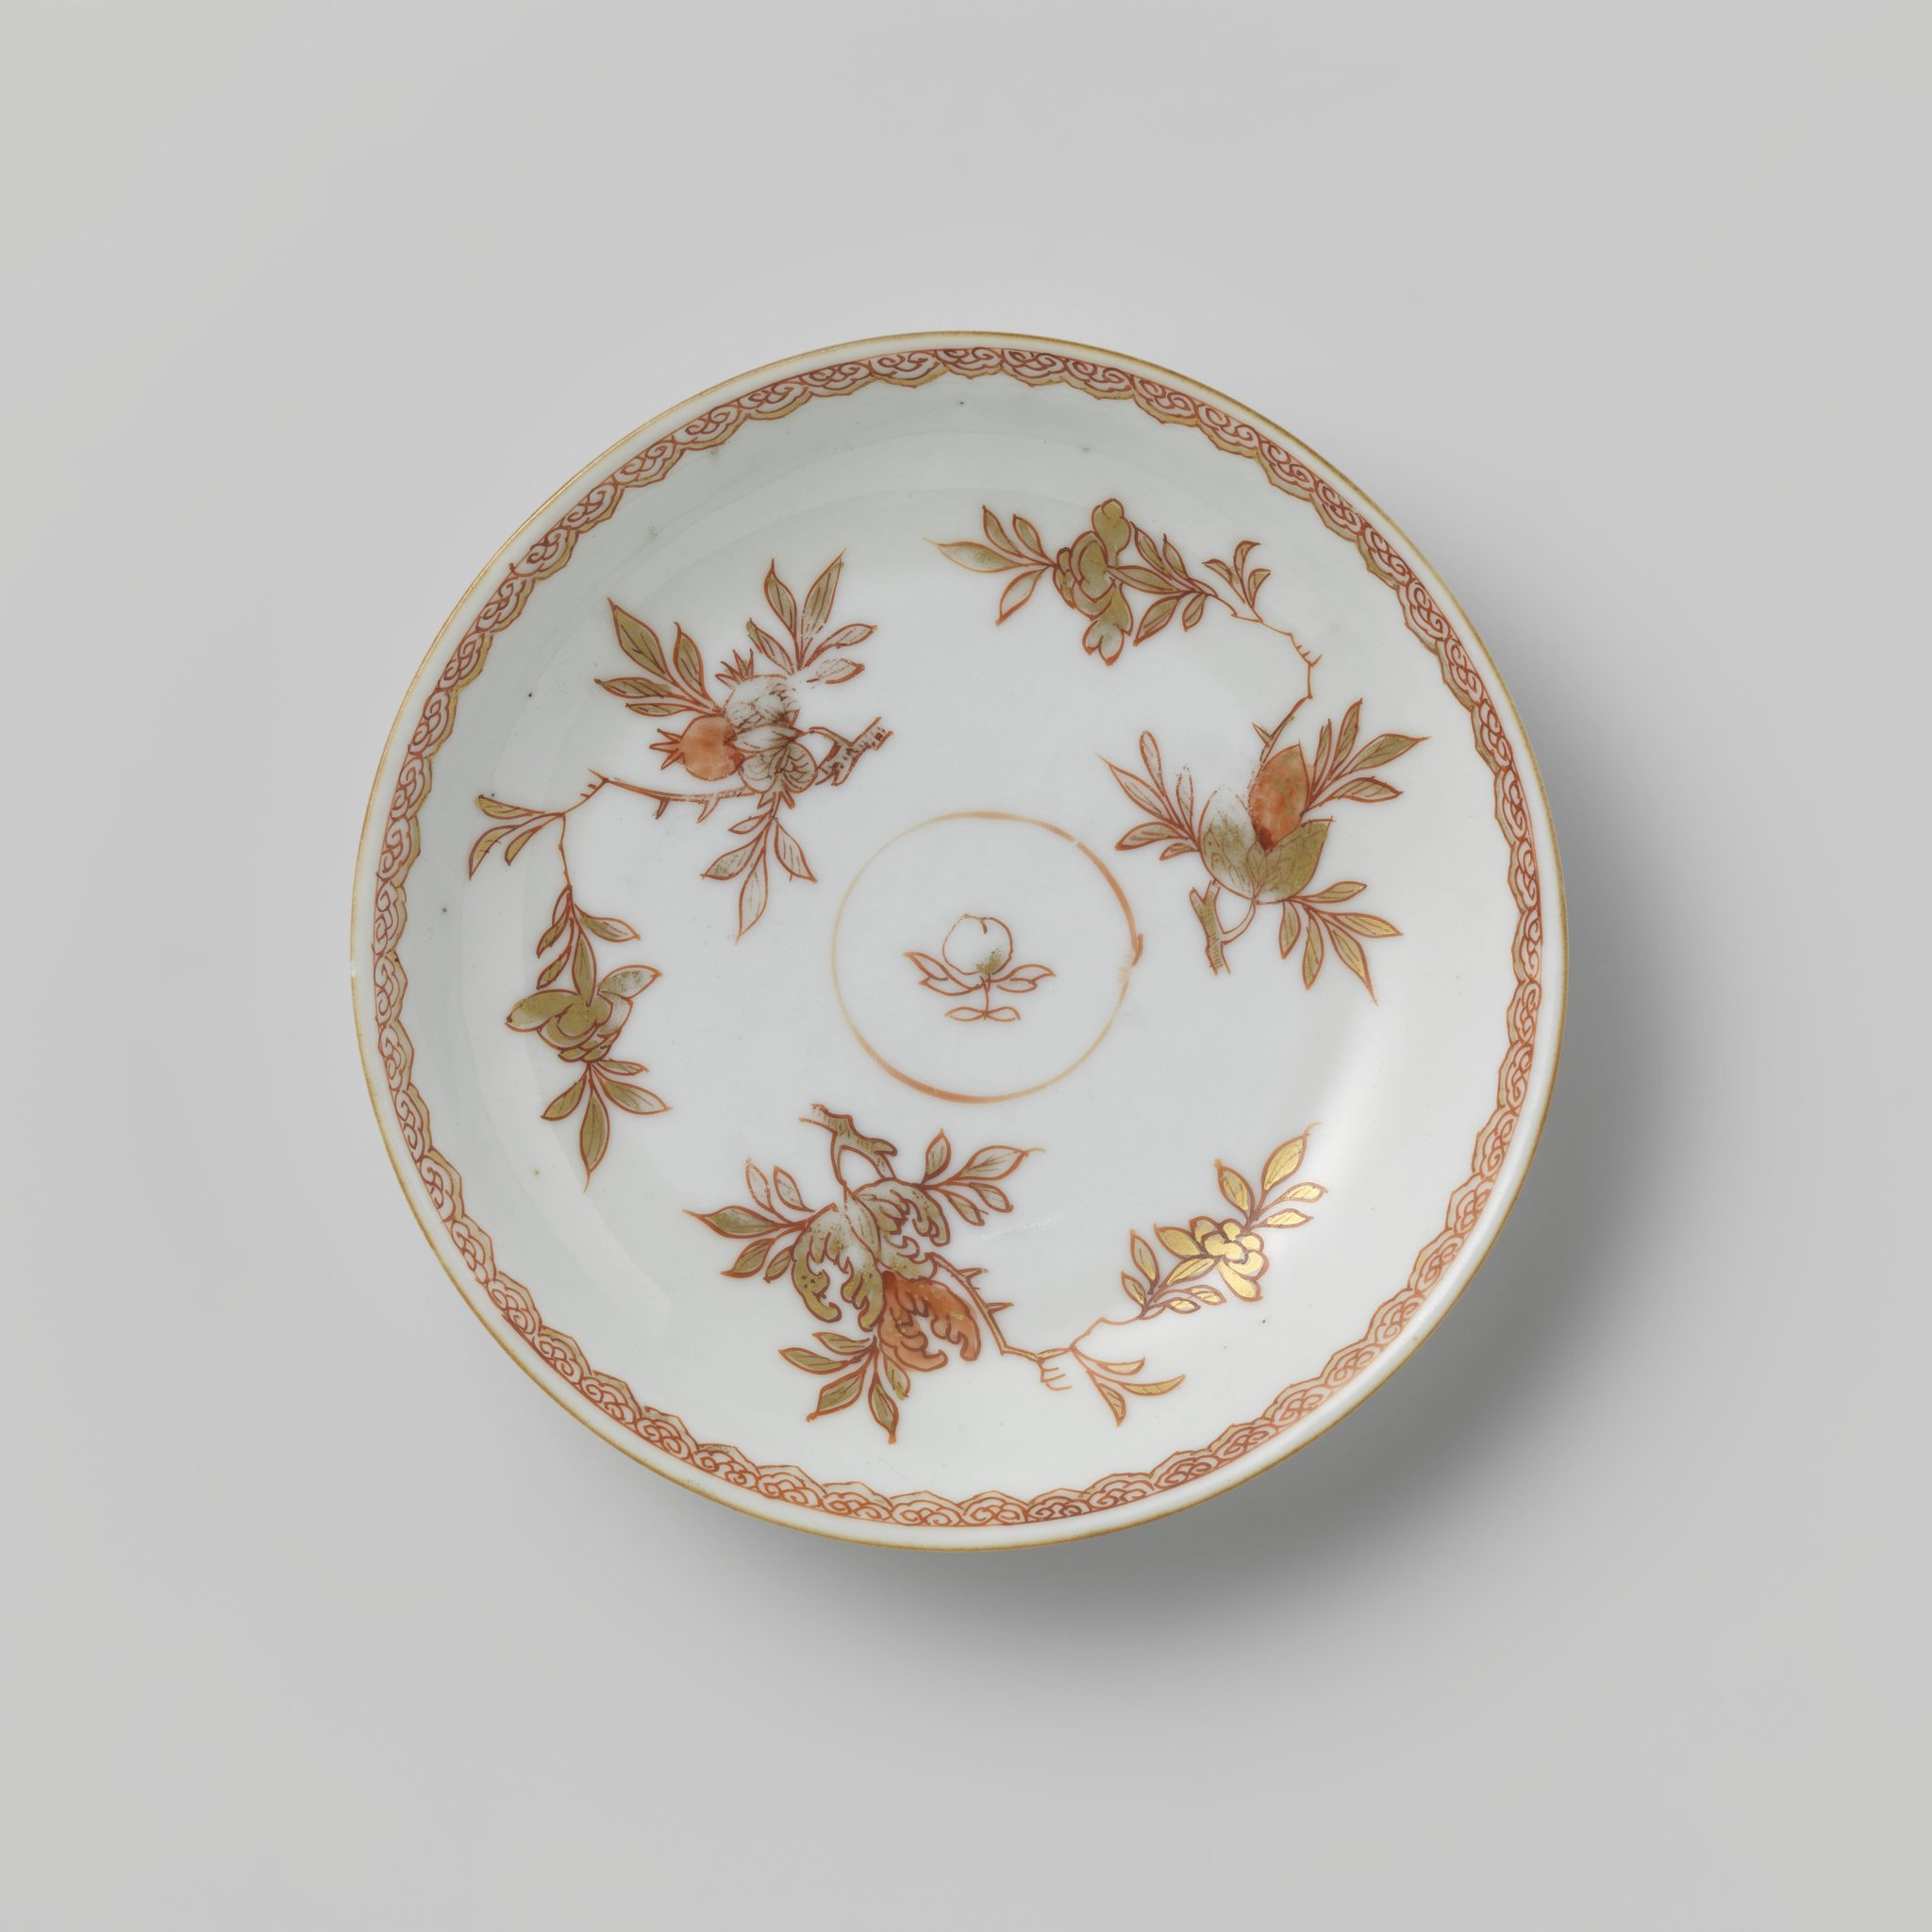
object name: platter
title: Saucer with fruit sprays and ruyi-border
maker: Anonymous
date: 1725-1749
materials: glaze, gold, paint, porcelain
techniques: firing, gilding, turning, vitrification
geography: china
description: Schotel van porselein, beschilderd op het glazuur met rood en goud. Op het plat een tak in een medaillon met daaromheen drie fruittakken, om de rand een band met ruyi-motief. Melk en bloed.